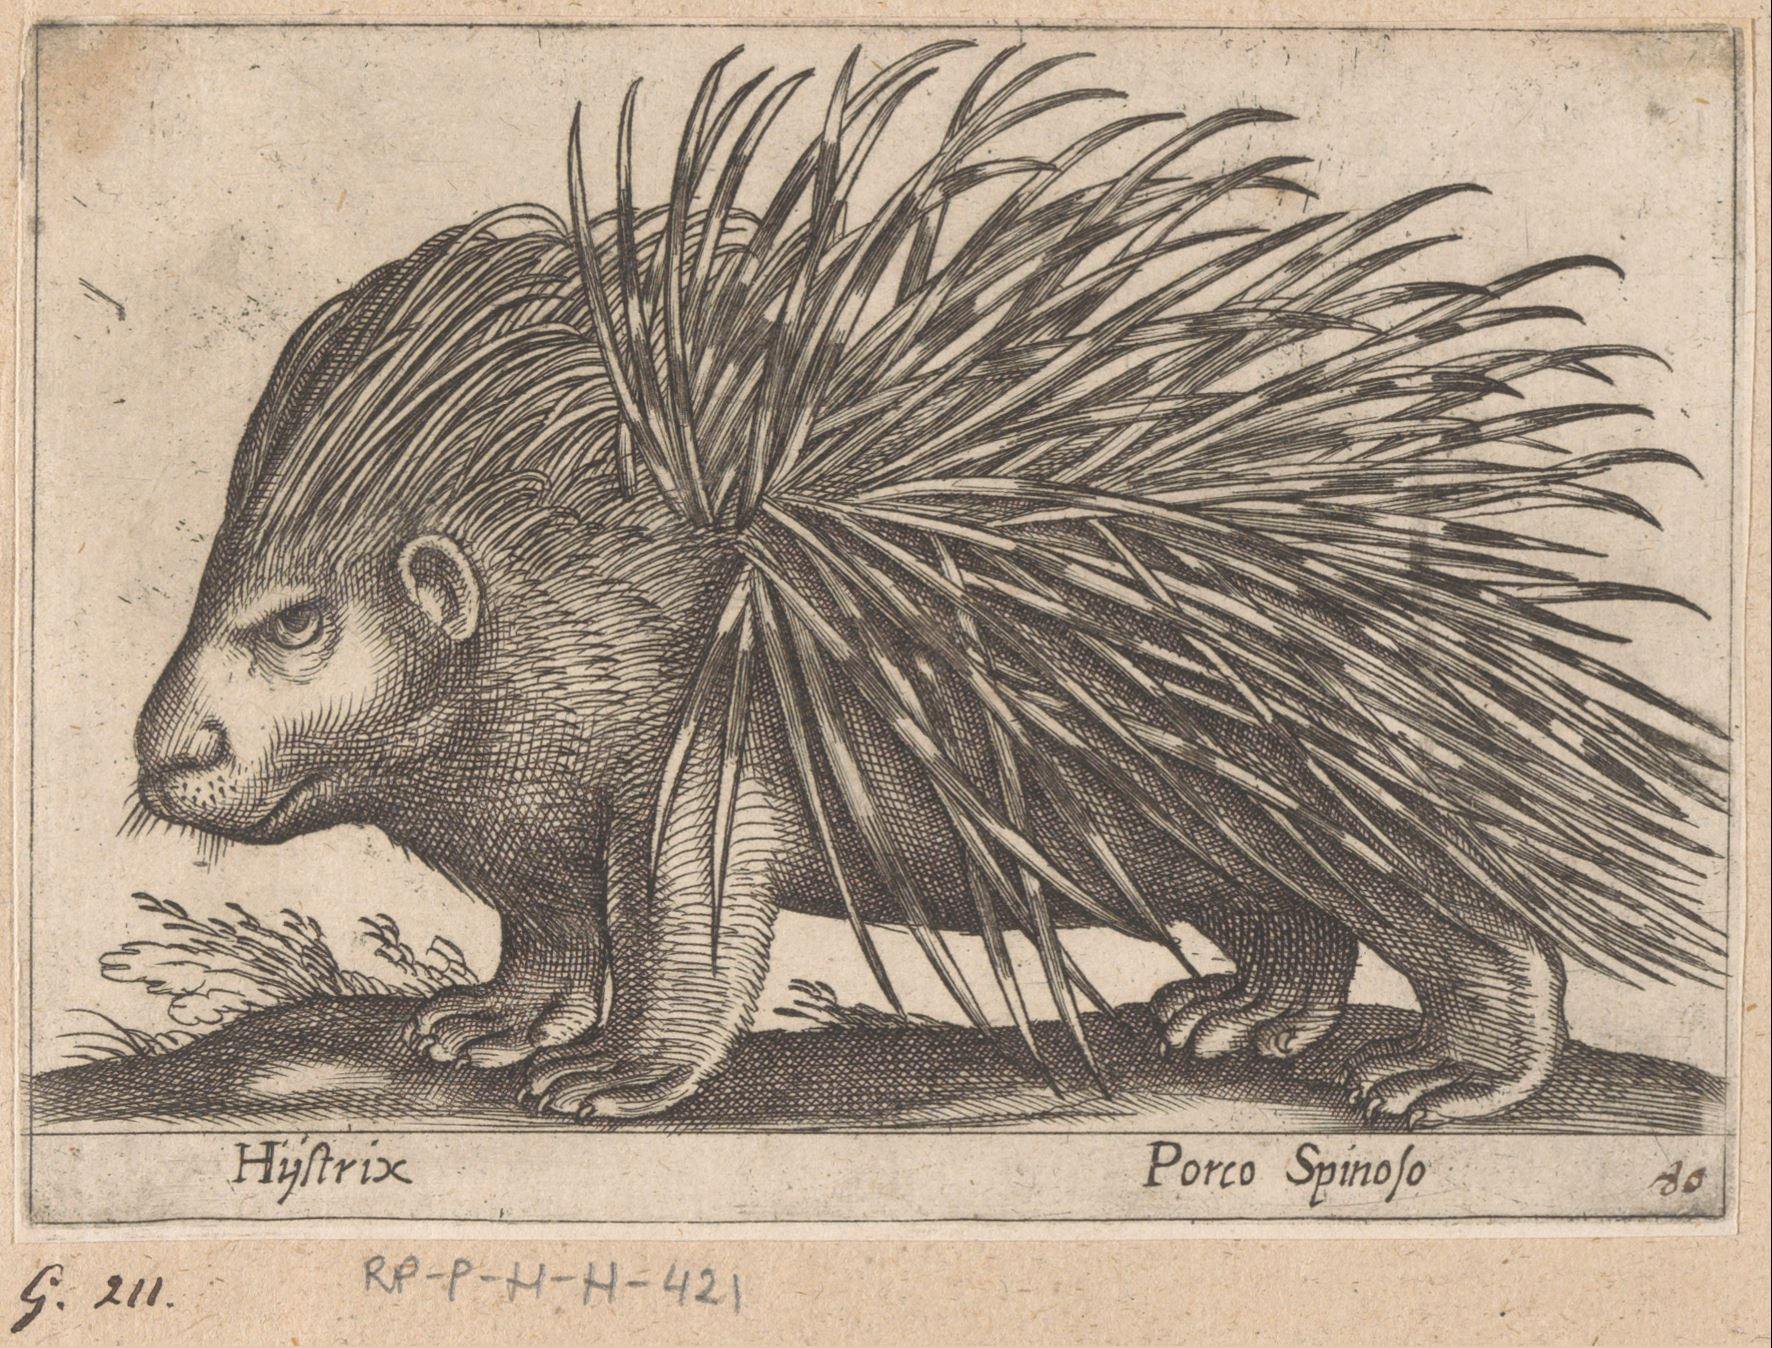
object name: print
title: Nova raccolta de li animali piu curiosi del mondo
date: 1565-1630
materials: paper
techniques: etching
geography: italy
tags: other mammals: porcupine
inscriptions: collector's mark: Lugt 11, number: ‘80’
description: Deze prent maakt deel uit van een reeks prenten van dieren door Antonio Tempesta. Bekend is dat een tweede staat (met nummering) van deze serie is uitgegeven door Giovanni Giacomo de' Rossi in 1650. Onbekend is wie de eerste staat heeft uitgegeven en wanneer.